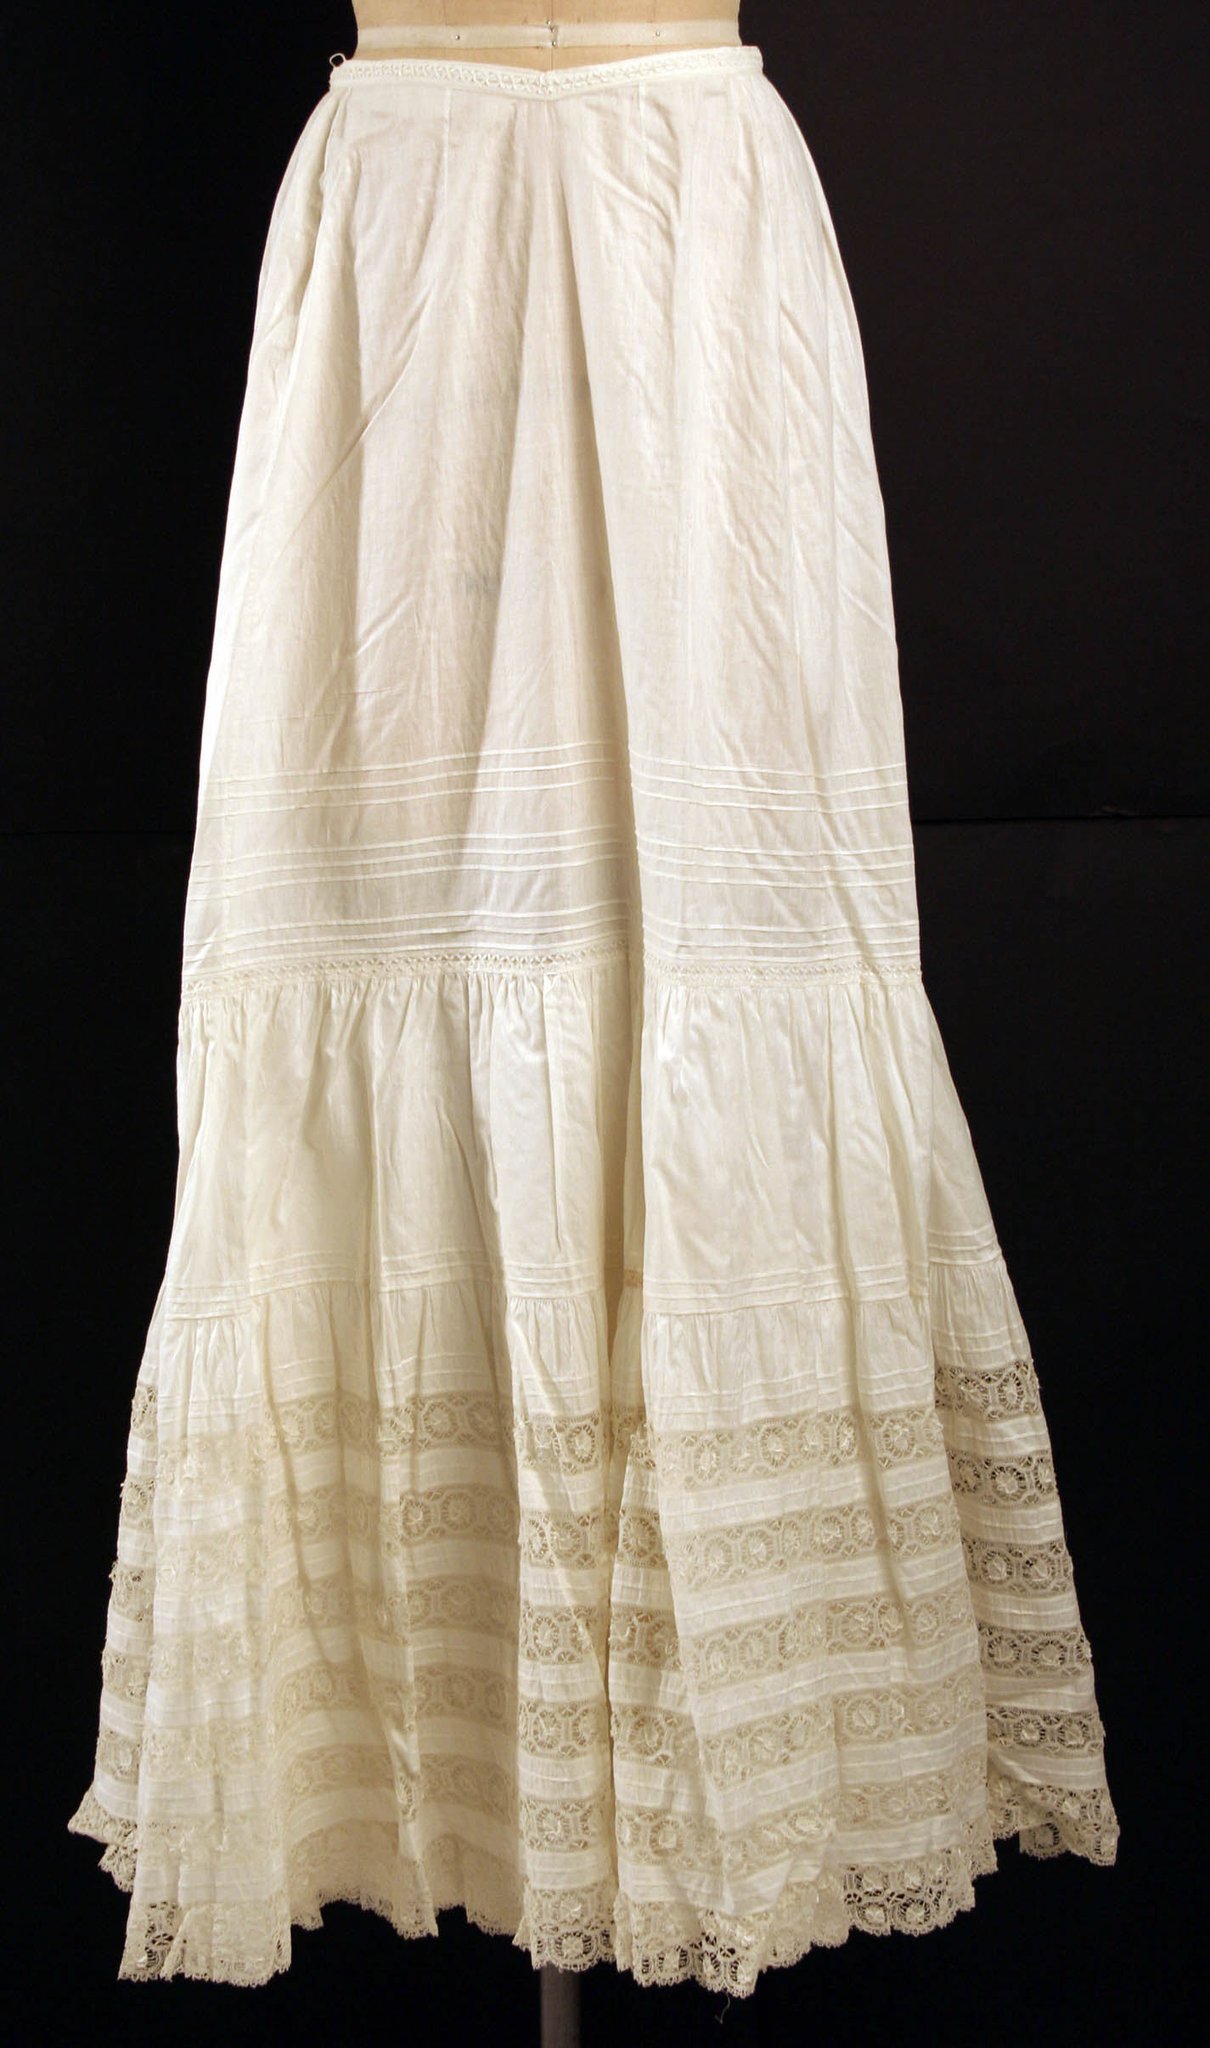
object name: underskirt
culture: american or european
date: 1875-1925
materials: cotton